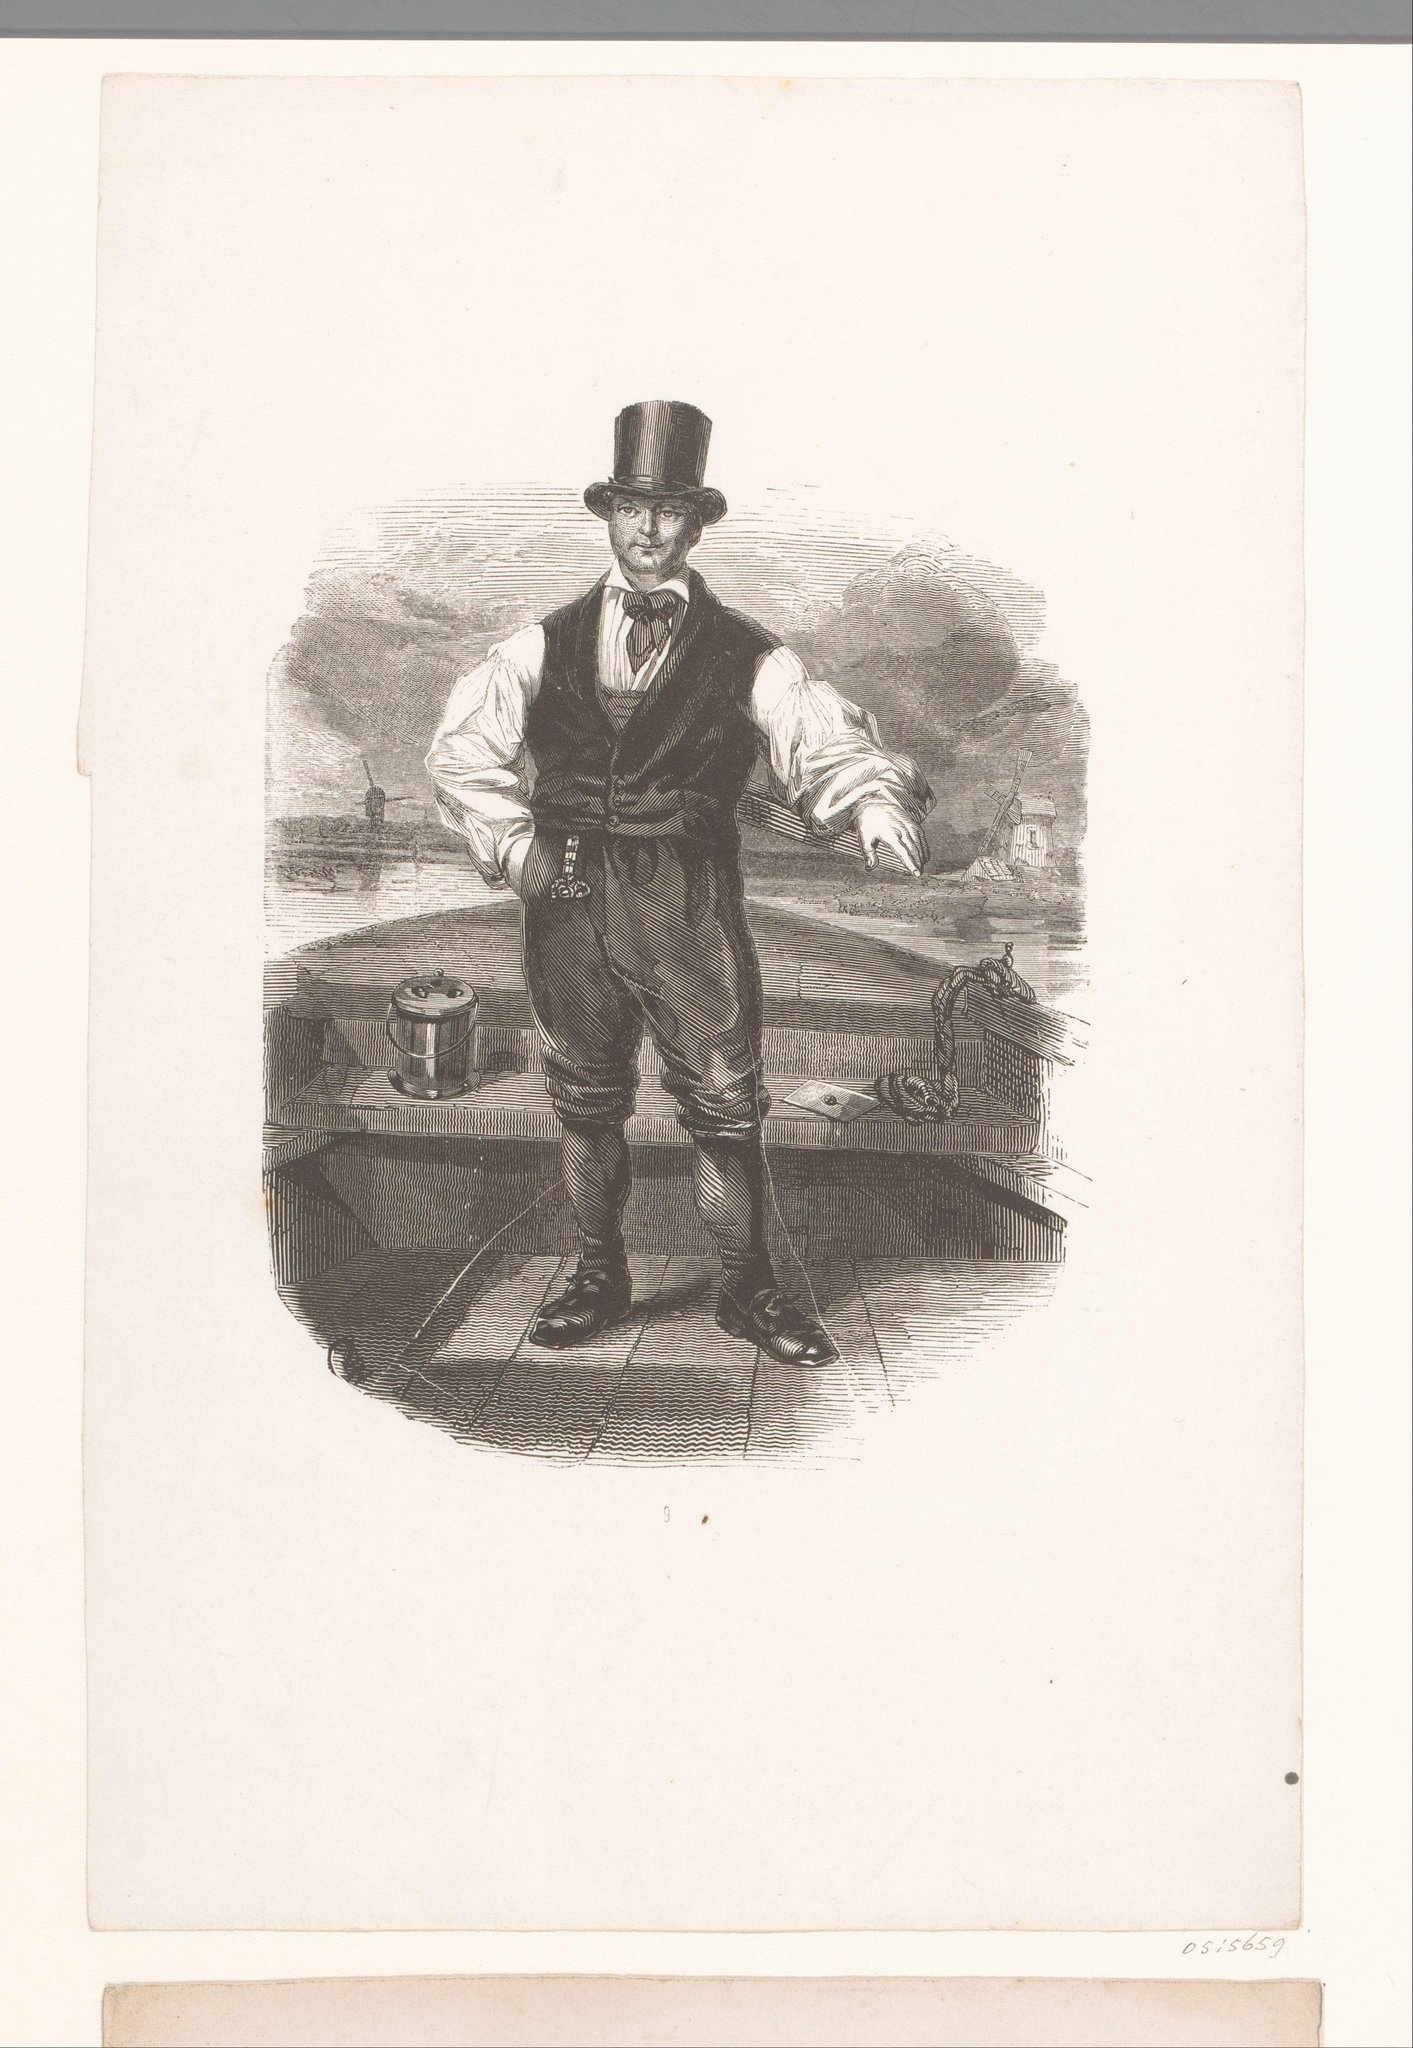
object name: print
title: Veerschipper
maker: henry brown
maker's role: print maker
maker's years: 1816-1870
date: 1841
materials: paper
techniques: engraving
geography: the hague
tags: crew ~ ship, professional clothes, standing figure, at the helm (manoeuvering), head-gear: hat, ferry, clothes, costume (+ men's clothes), traffic on the water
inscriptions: collector's mark: Lugt 2228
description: Prent uit: Brown, Henry. De Nederlanden: karakterschetsen, kleederdragten, houding en voorkomen van verschillende standen. Den Haag: Nederlandsche Maatschappij van Schoone Kunsten, 1841.